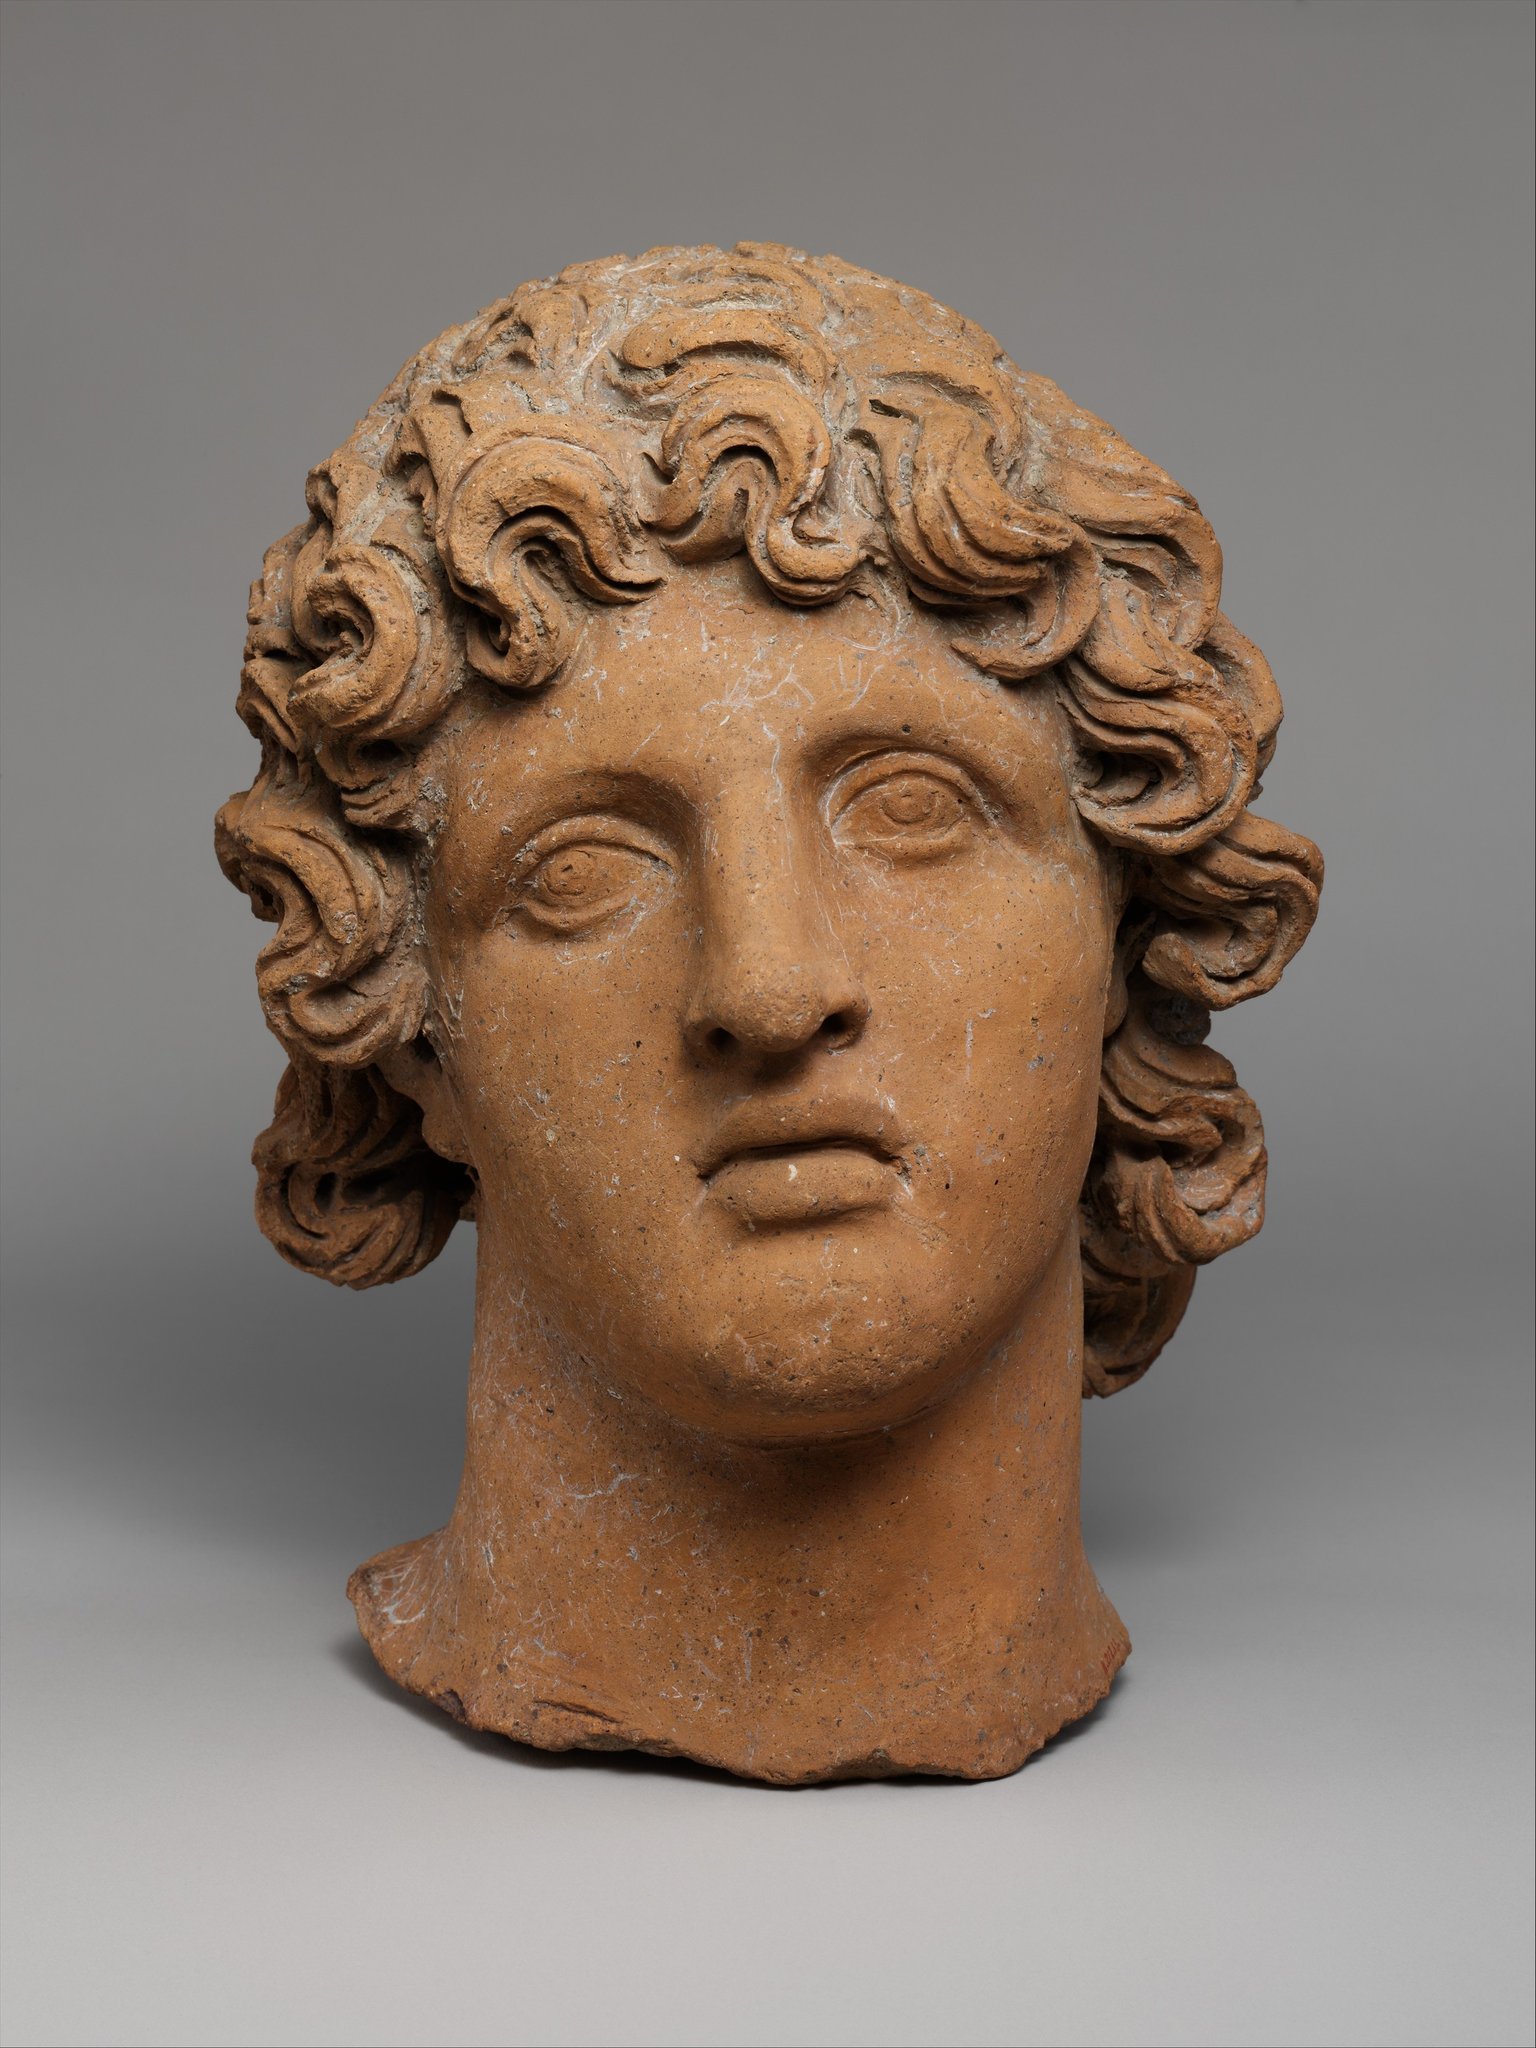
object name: head of a youth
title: Terracotta head of a youth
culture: etruscan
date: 300-101 BCE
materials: terracotta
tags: heads,boys